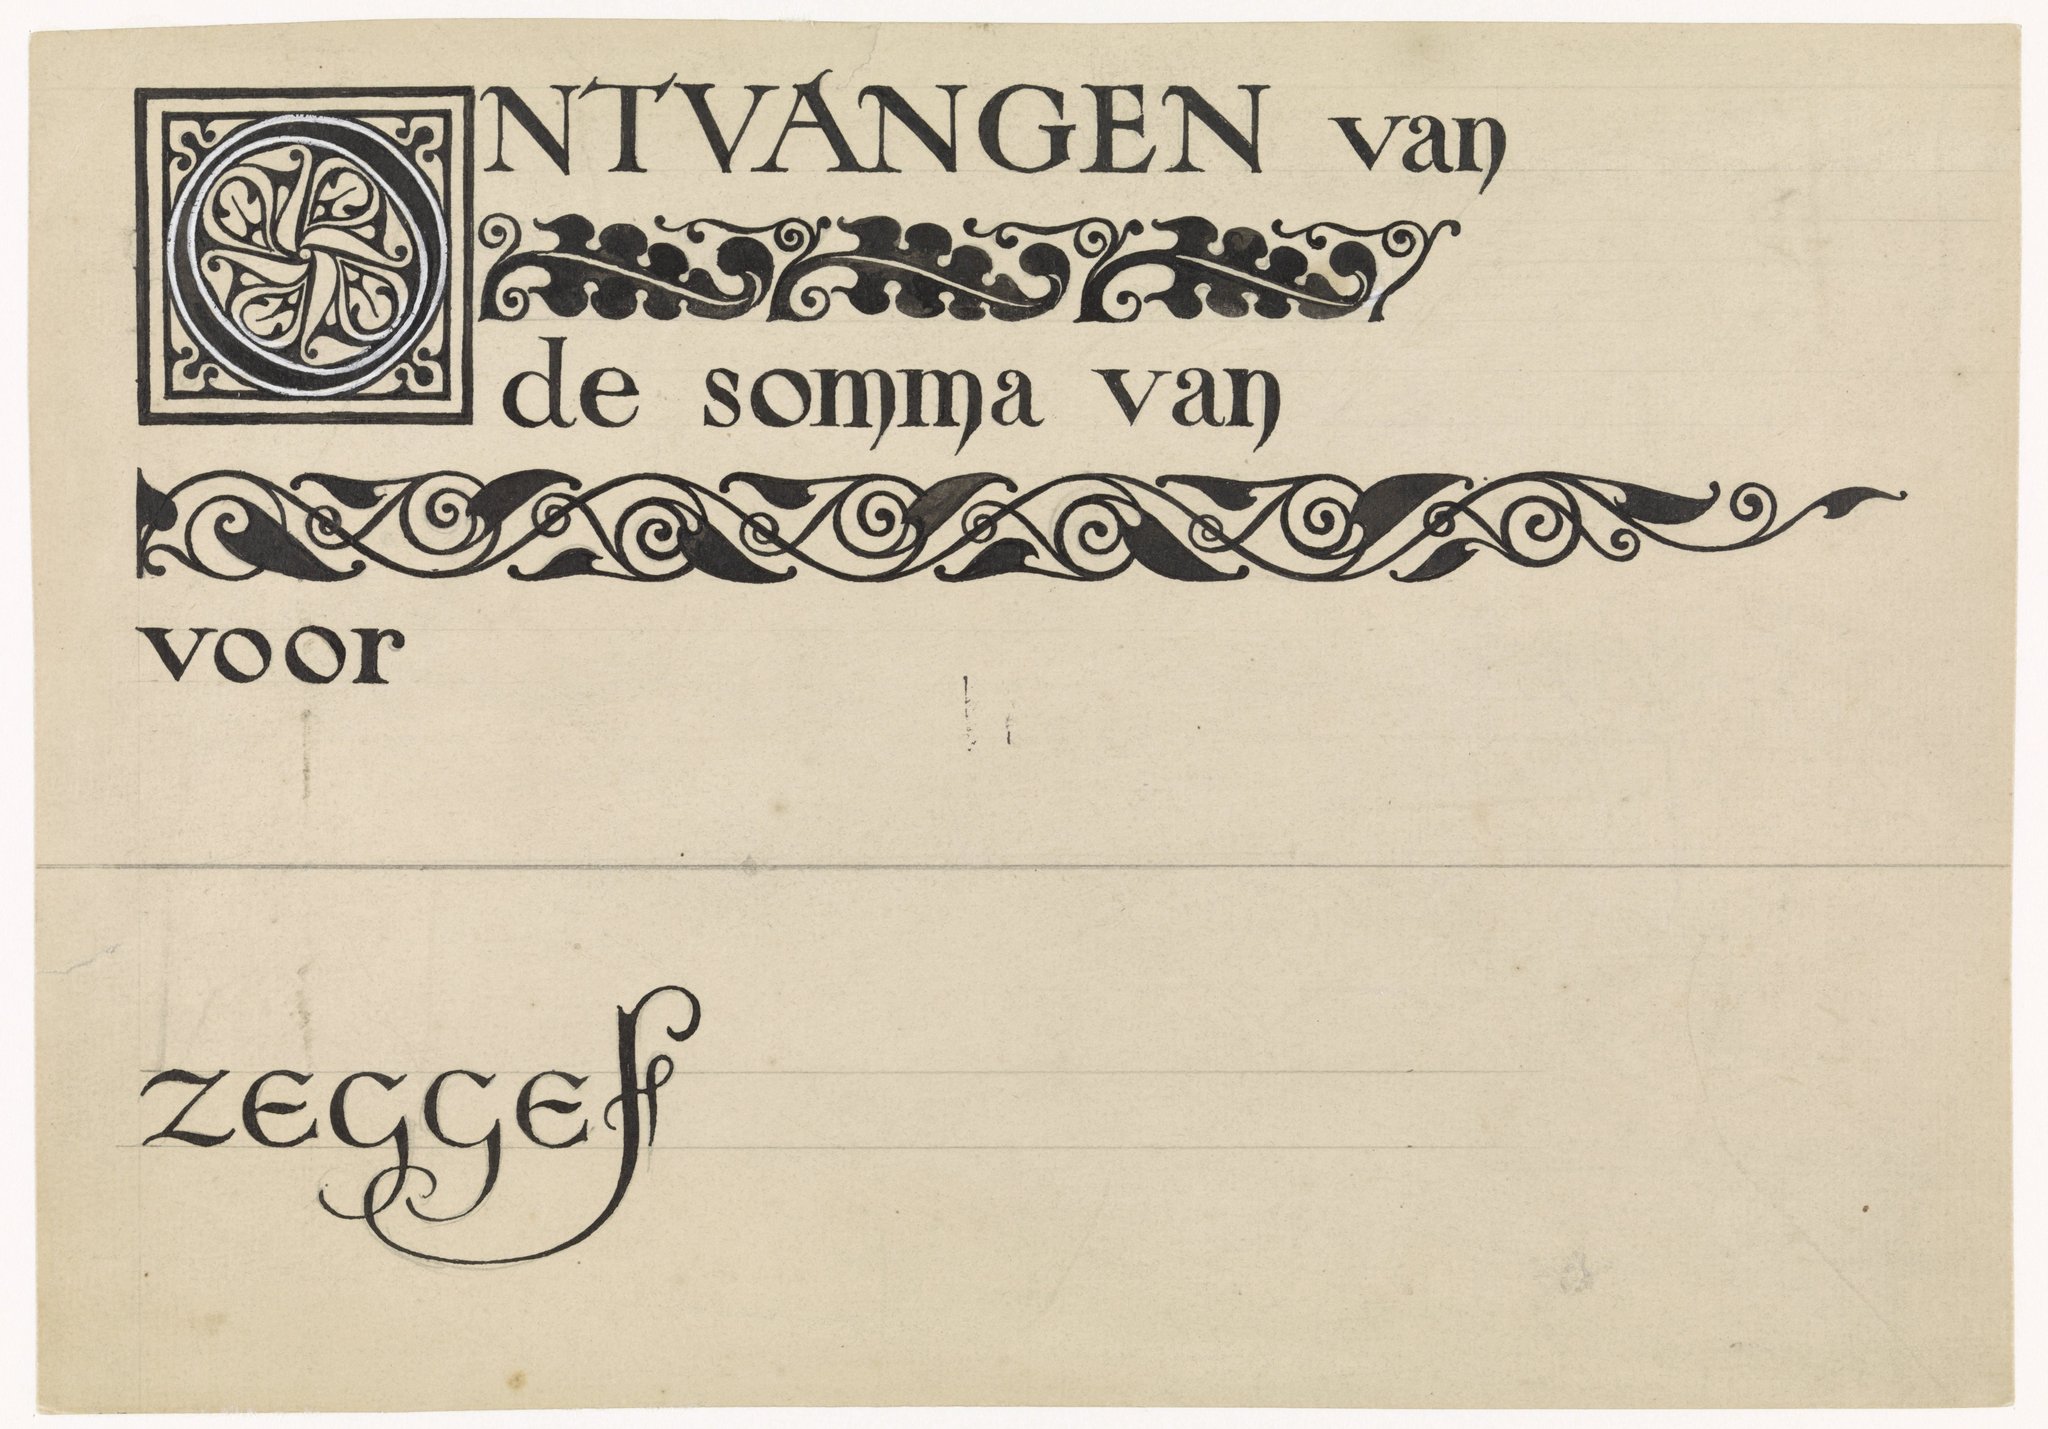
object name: drawing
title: Ontwerp voor een kwitantie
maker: antoon derkinderen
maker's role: draughtsman, painter, print maker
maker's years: 1859-1925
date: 1869-1925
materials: paint, paper, pencil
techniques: brush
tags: auxiliary means and methods in trade and finance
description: Ontwerp voor een kwitantie voor de glas-in-lood werkplaats van A.J. Derkinderen of van de architect Hanrath.